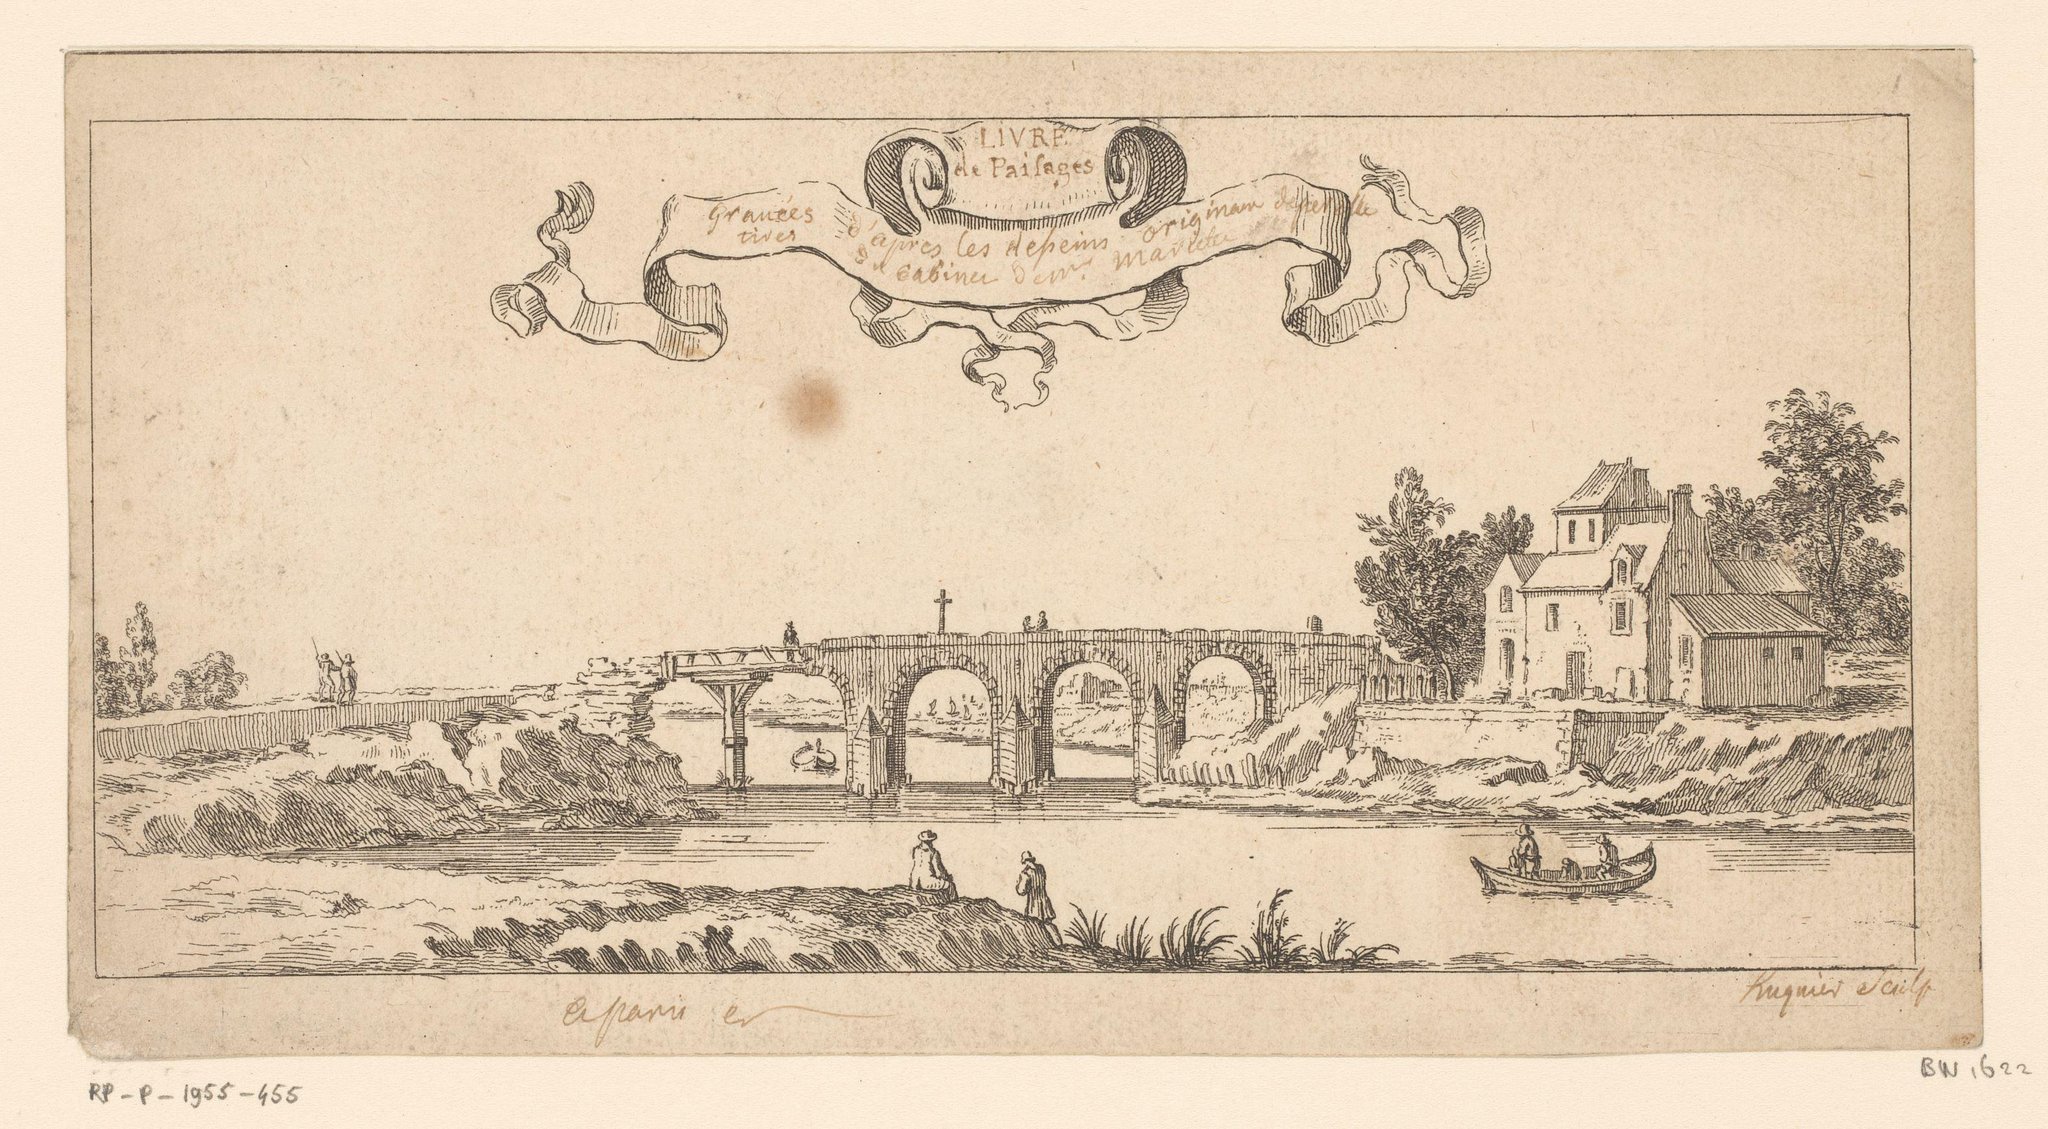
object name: print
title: Livre de Paisages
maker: gabriel huquier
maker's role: painter, print maker, publisher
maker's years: 1695-1772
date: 1705-1772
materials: paper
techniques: etching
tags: landscape with bridge, viaduct or aqueduct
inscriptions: collector's mark: Lugt 2760, inscription, collector's mark: Lugt 2228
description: Titelprent van een serie getiteld 'Livre de Paisages'. De serie bestaat uit twaalf prenten met verschillende landschappen door Huquier.